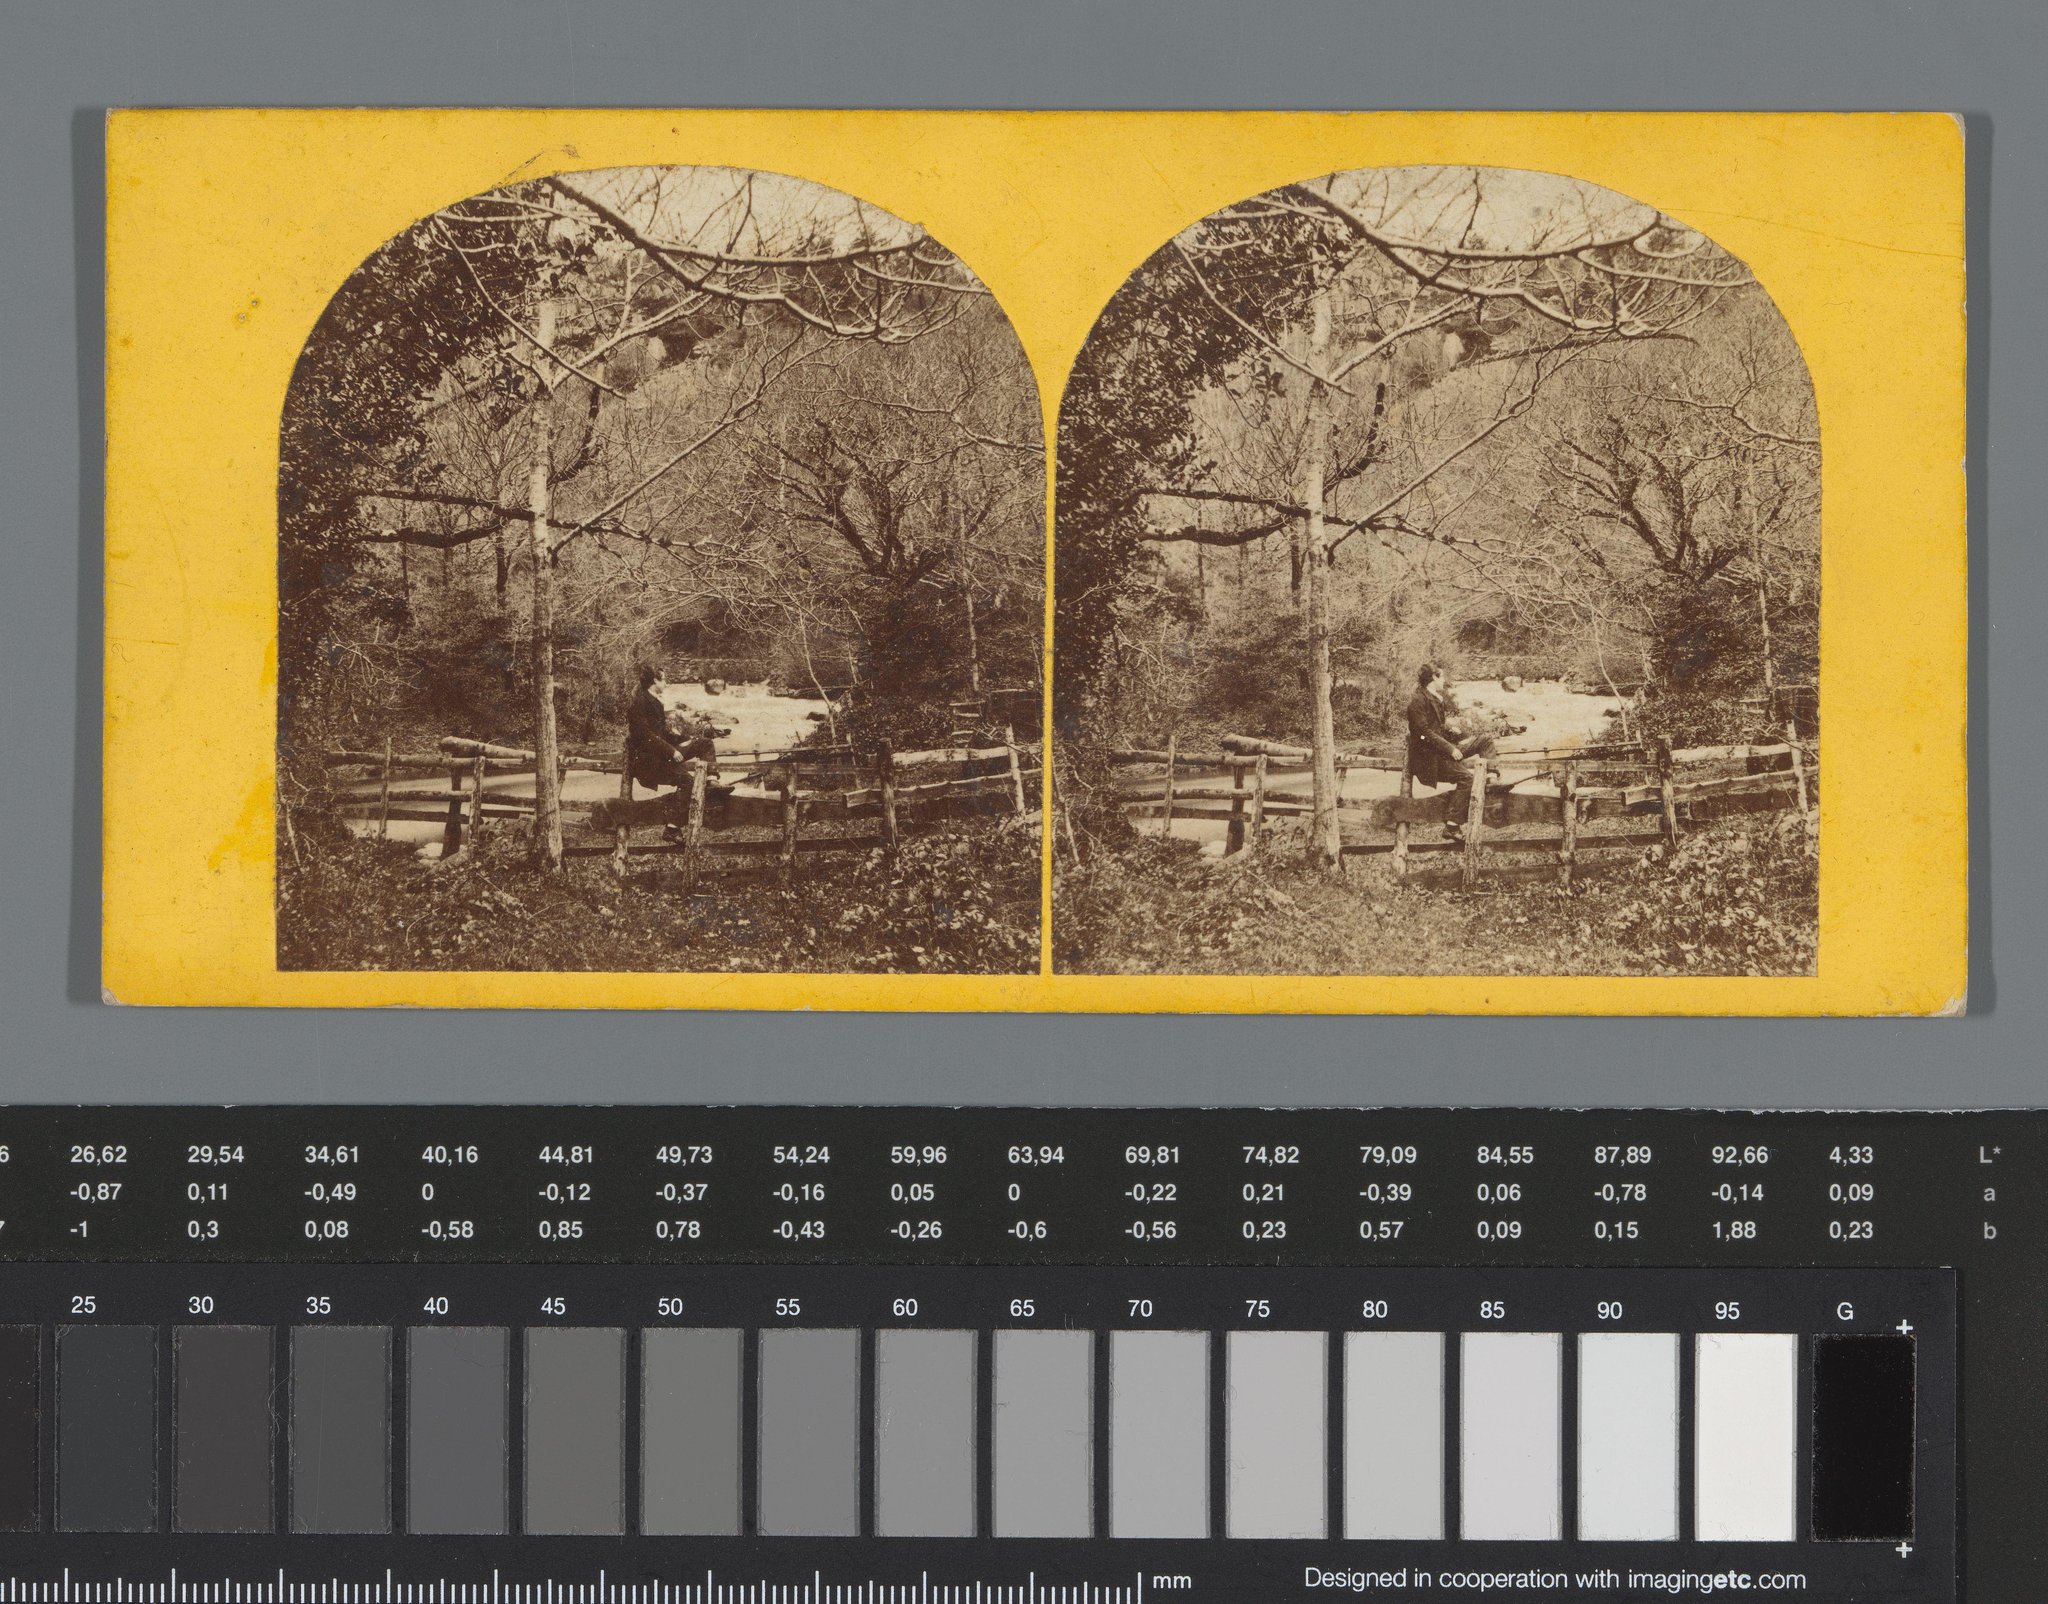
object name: stereograph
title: Devil's Glen in Wicklow, Ierland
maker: Anonymous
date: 1861-1870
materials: cardboard, paper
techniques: albumen print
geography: wicklow mountains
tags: river bank, forest, wood